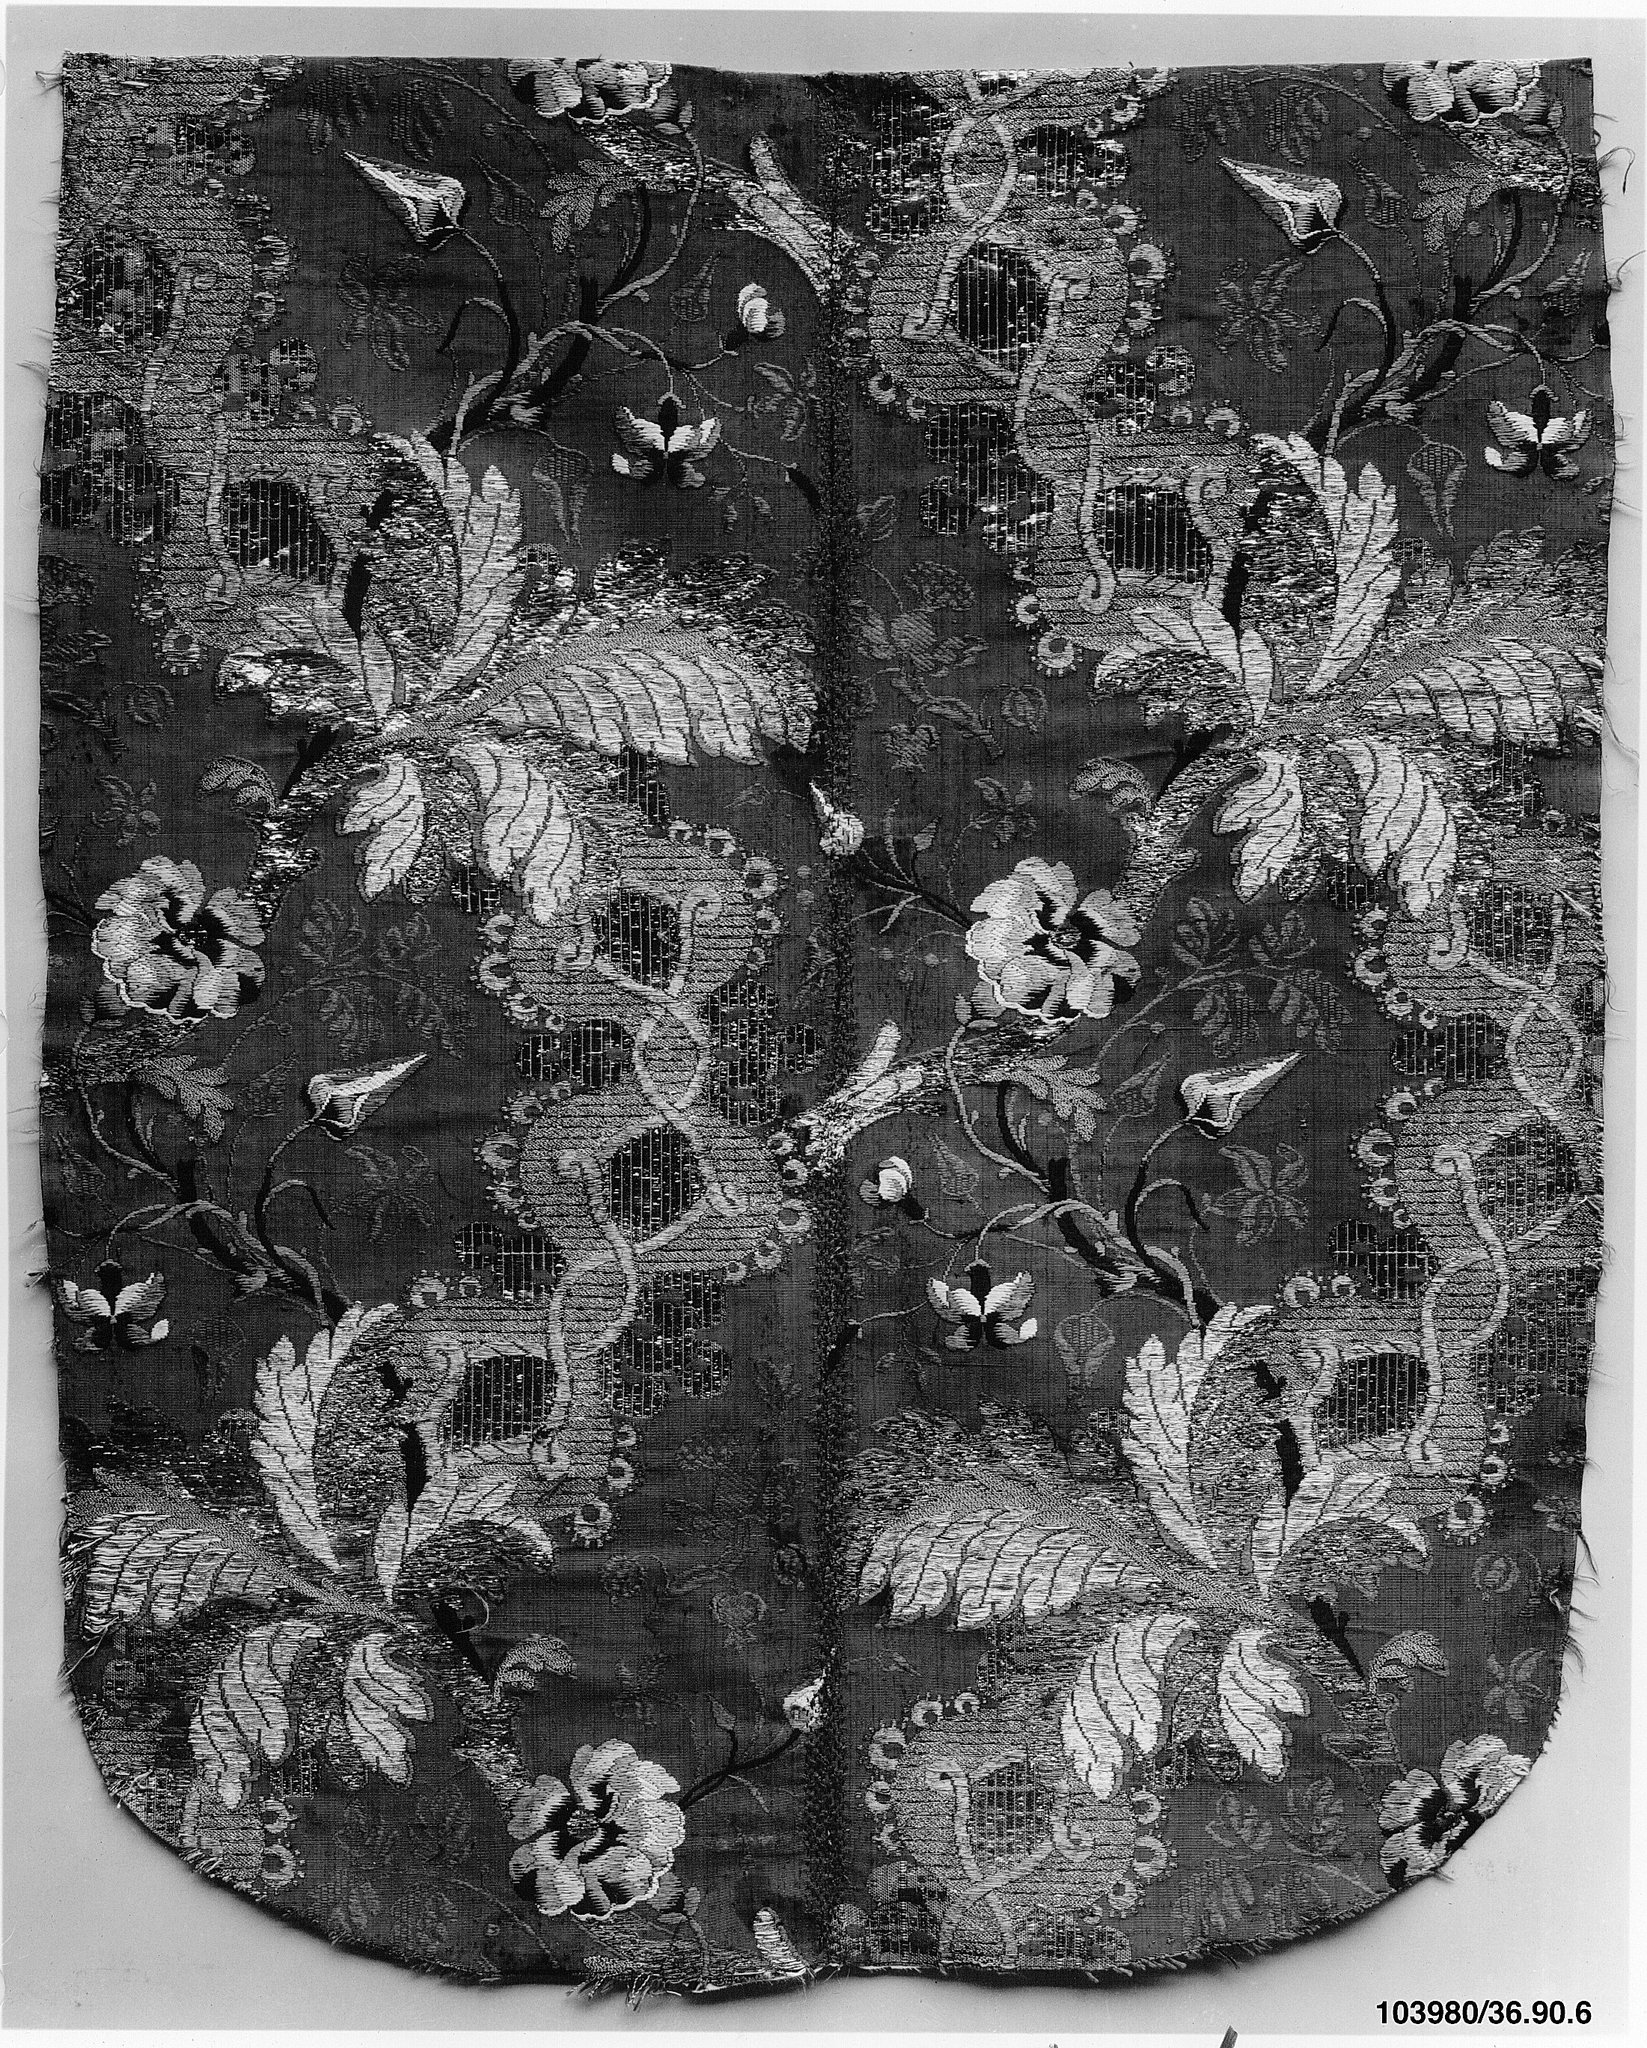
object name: piece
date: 1760-1770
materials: metal thread, silk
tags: flowers,leaves